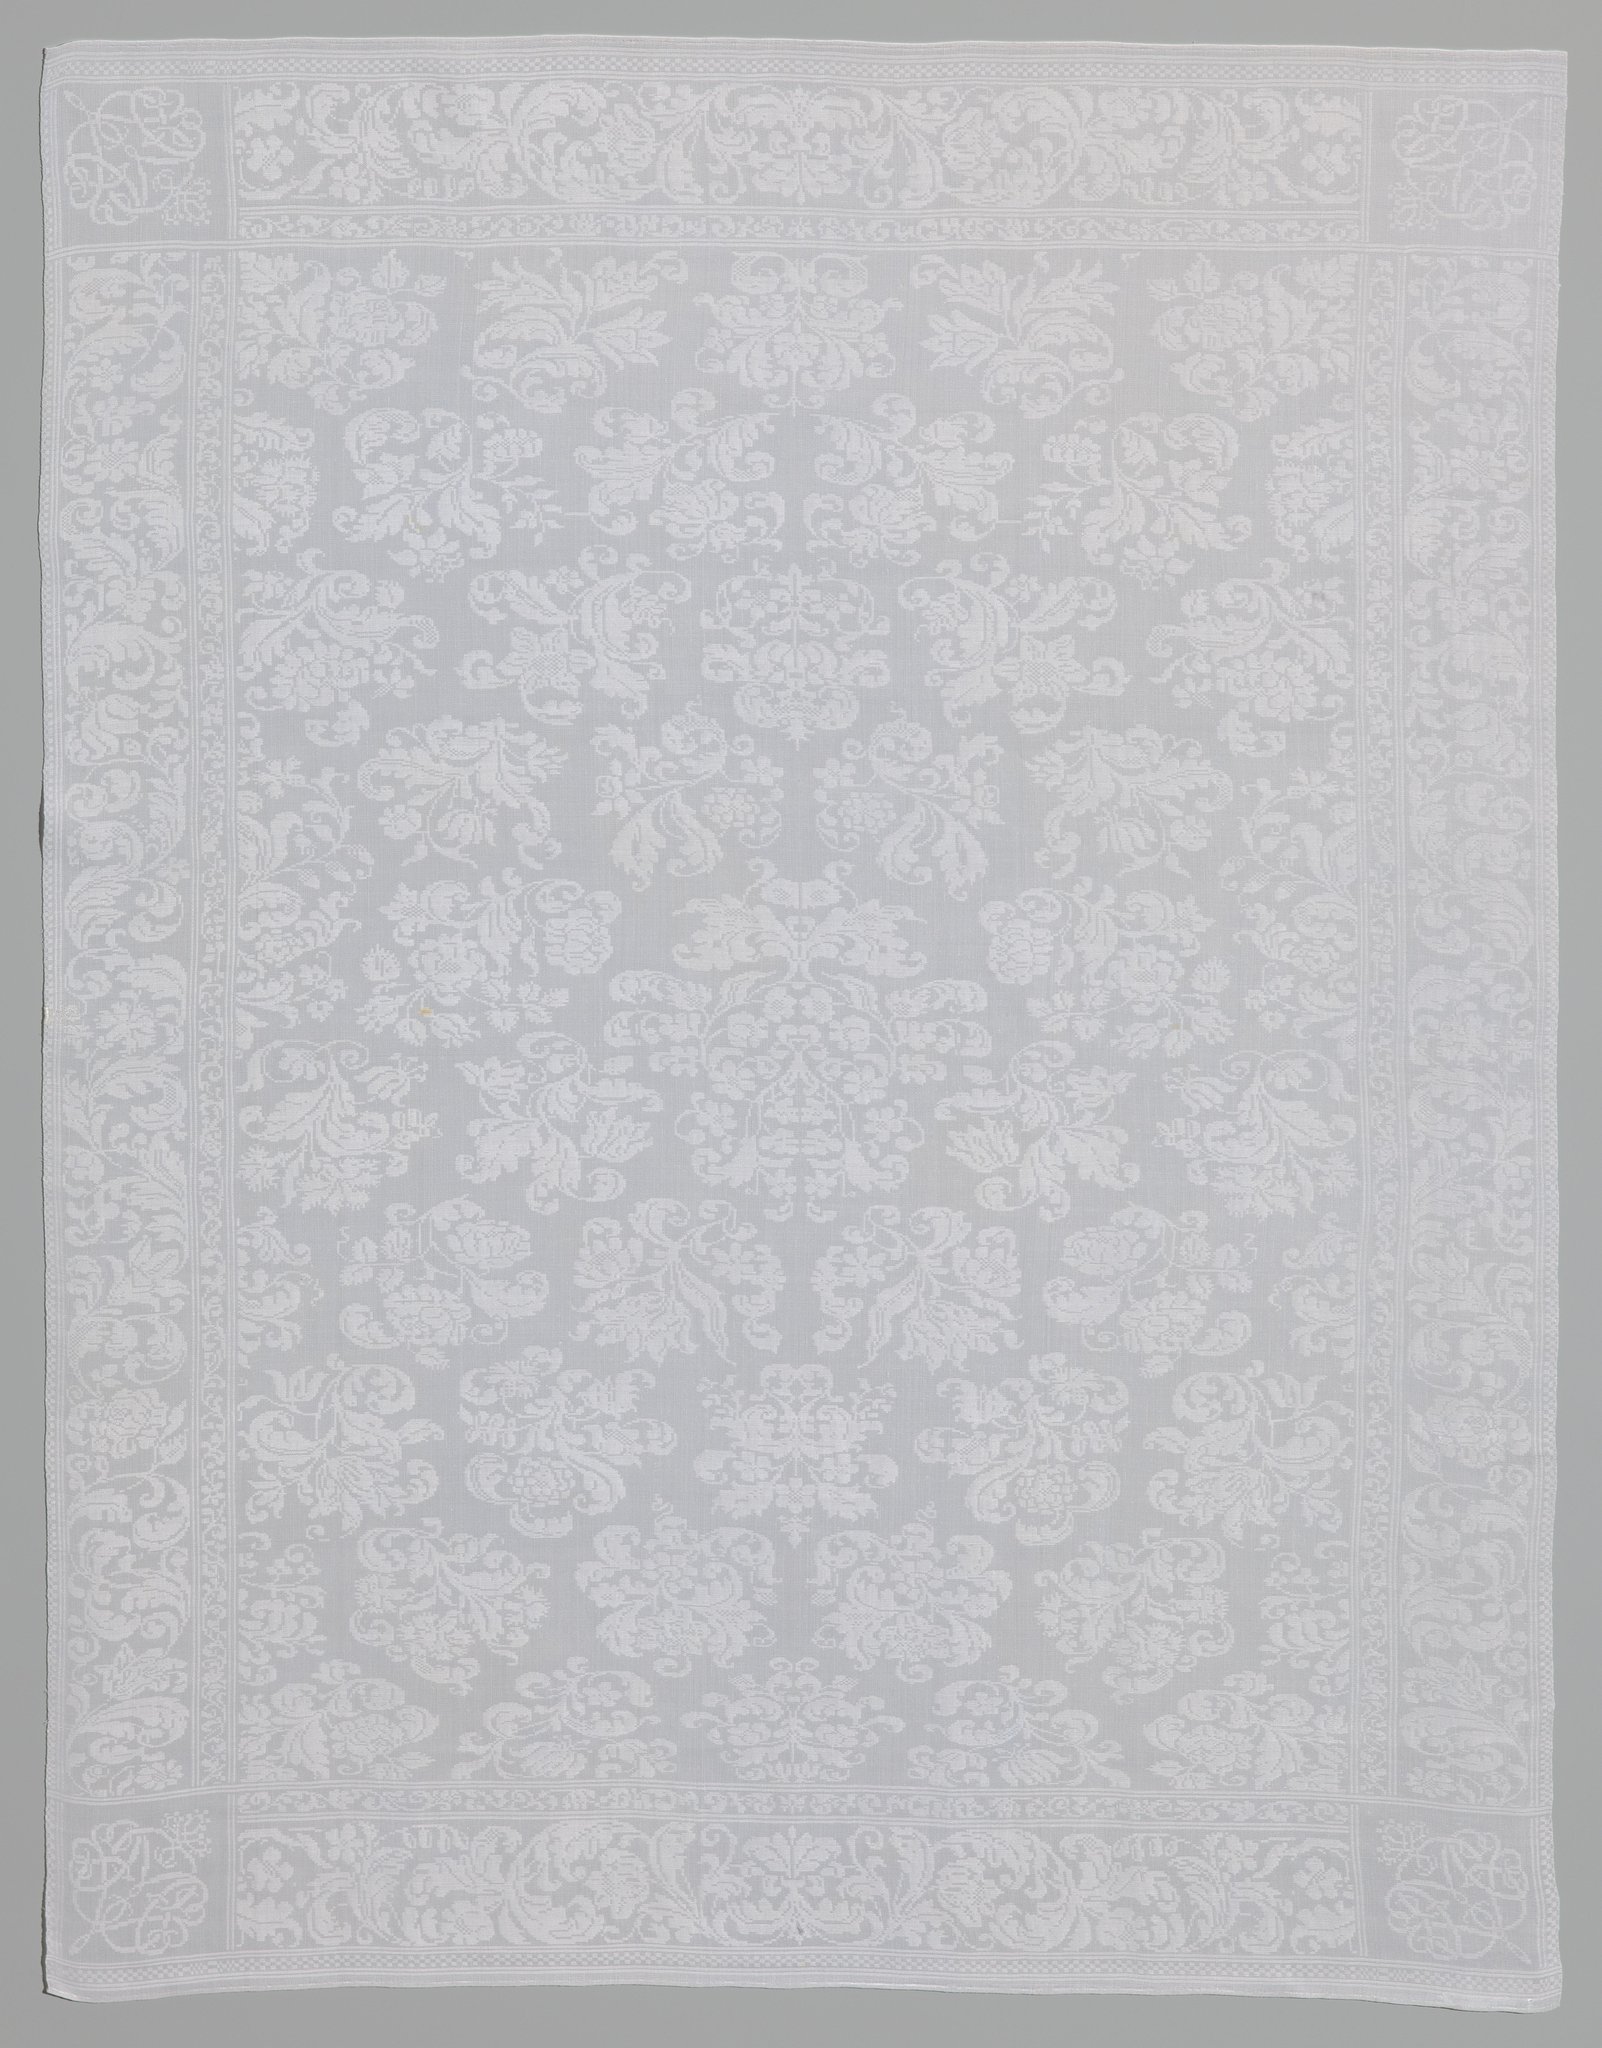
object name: napkin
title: Servet van wit linnendamast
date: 1680-1690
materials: linen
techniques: damask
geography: northern netherlands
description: Wit linnen damasten servet, versierd met gestrooide bloemtak en ingeweven gekroond spiegelmonogram.